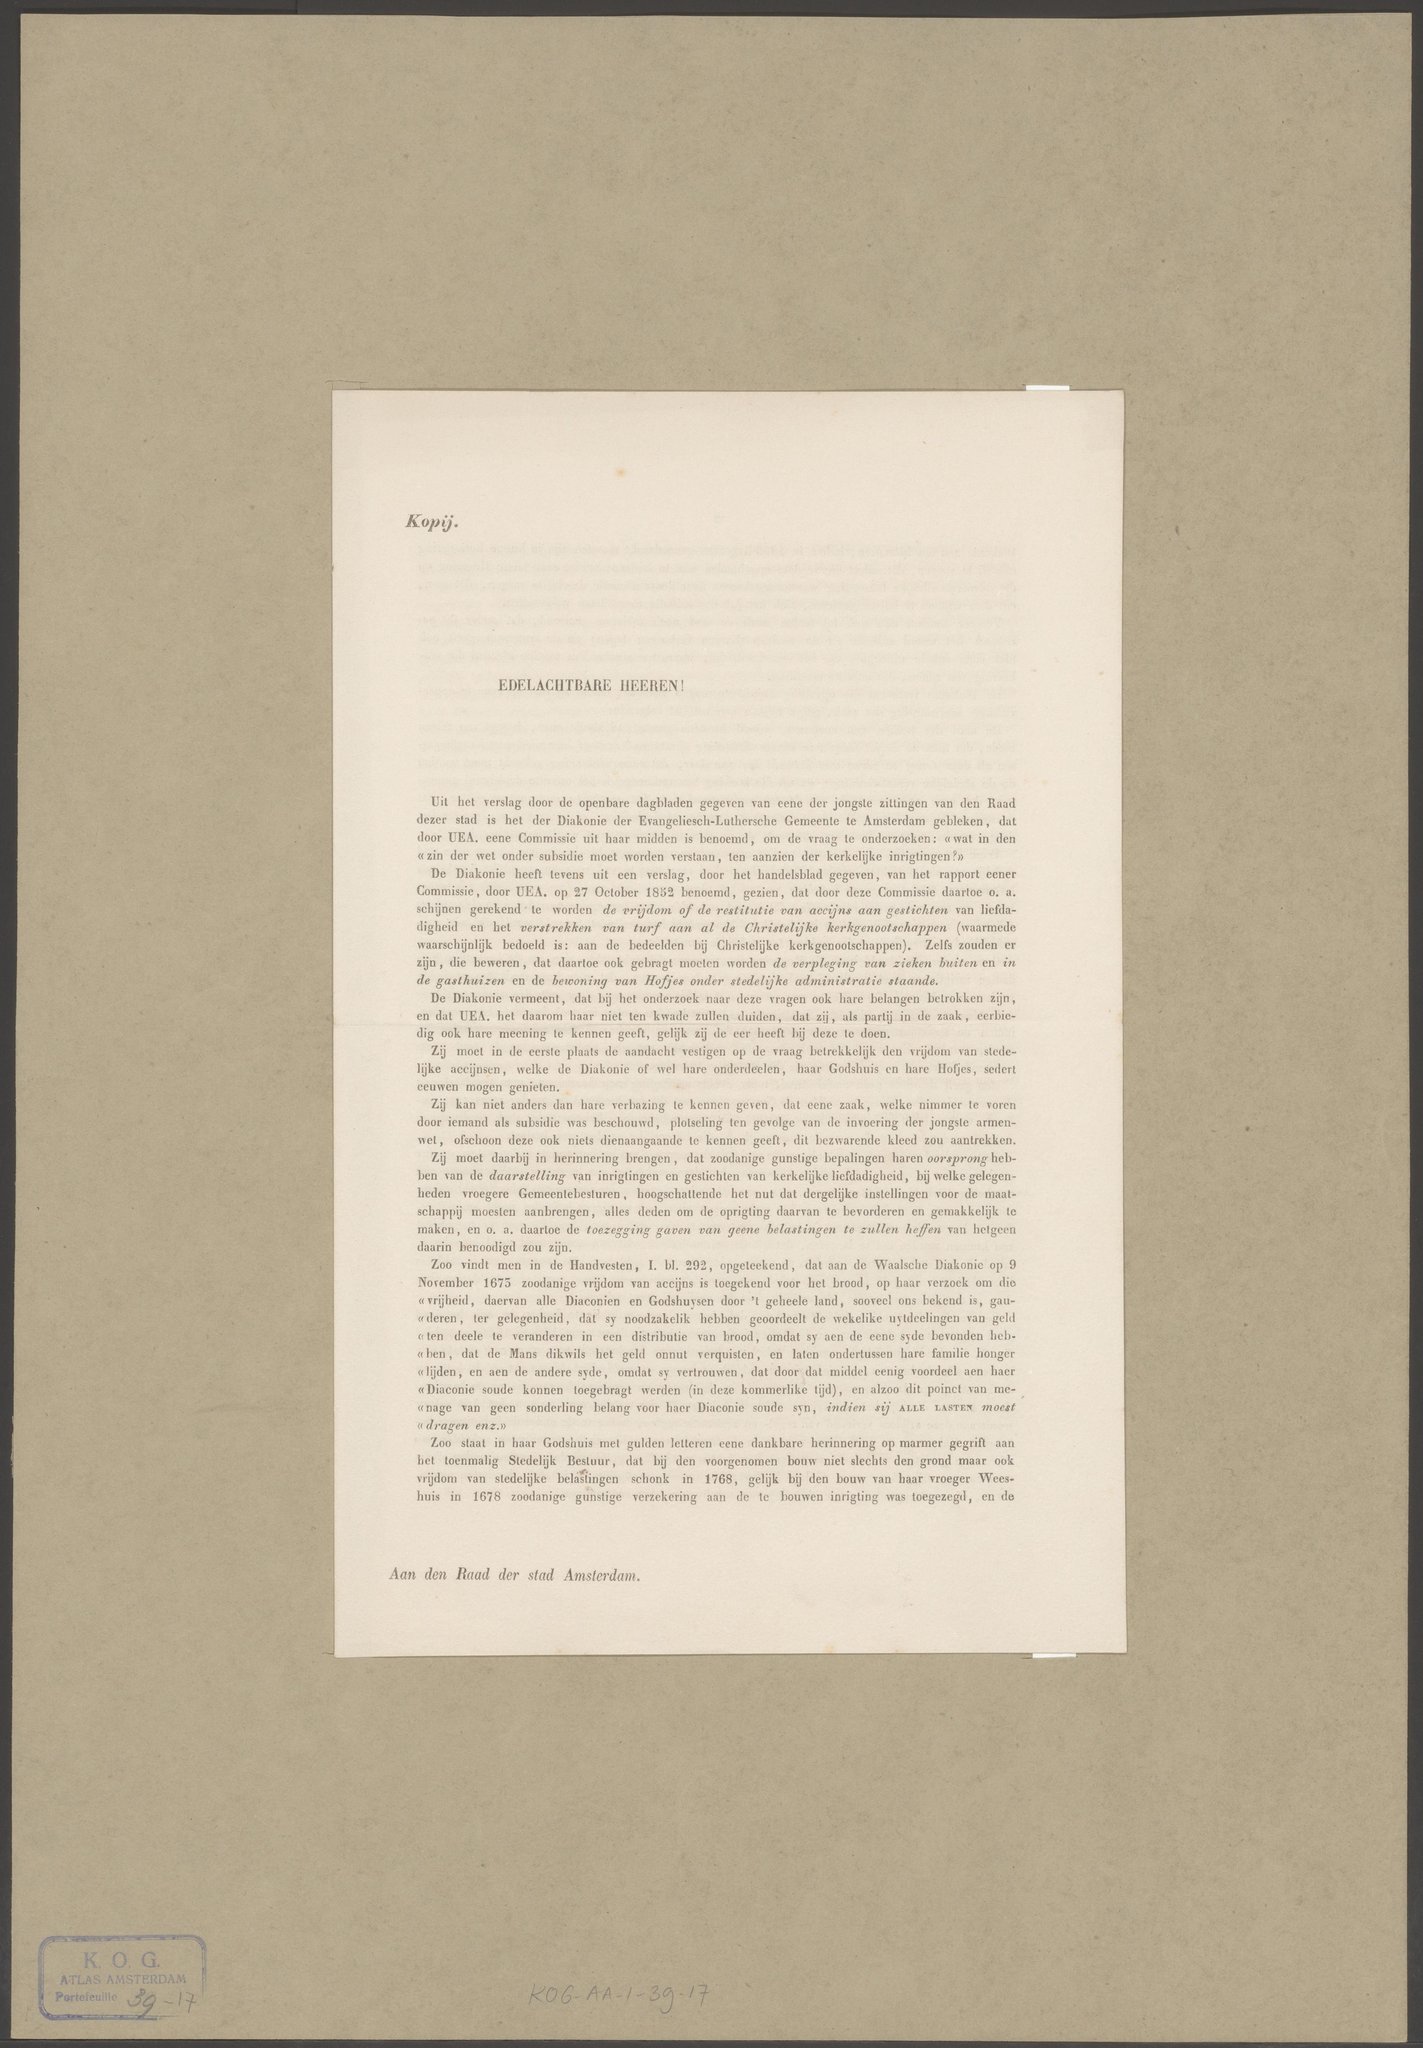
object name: letter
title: Brief van de Evangelisch-Lutherse Diaconie aan het stadsbestuur van Amsterdam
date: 1855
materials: paper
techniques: letterpress printing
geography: amsterdam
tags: public welfare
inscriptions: collector's mark: Lugt 1641b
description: Object bestaat uit een bifolium. Onderwerpsrubriek binnen de Atlas Amsterdam: Armwezen en liefdadige instellingen: II. Kerkelijke inrichtingen: Inrichtingen der Evang. Luthersen.